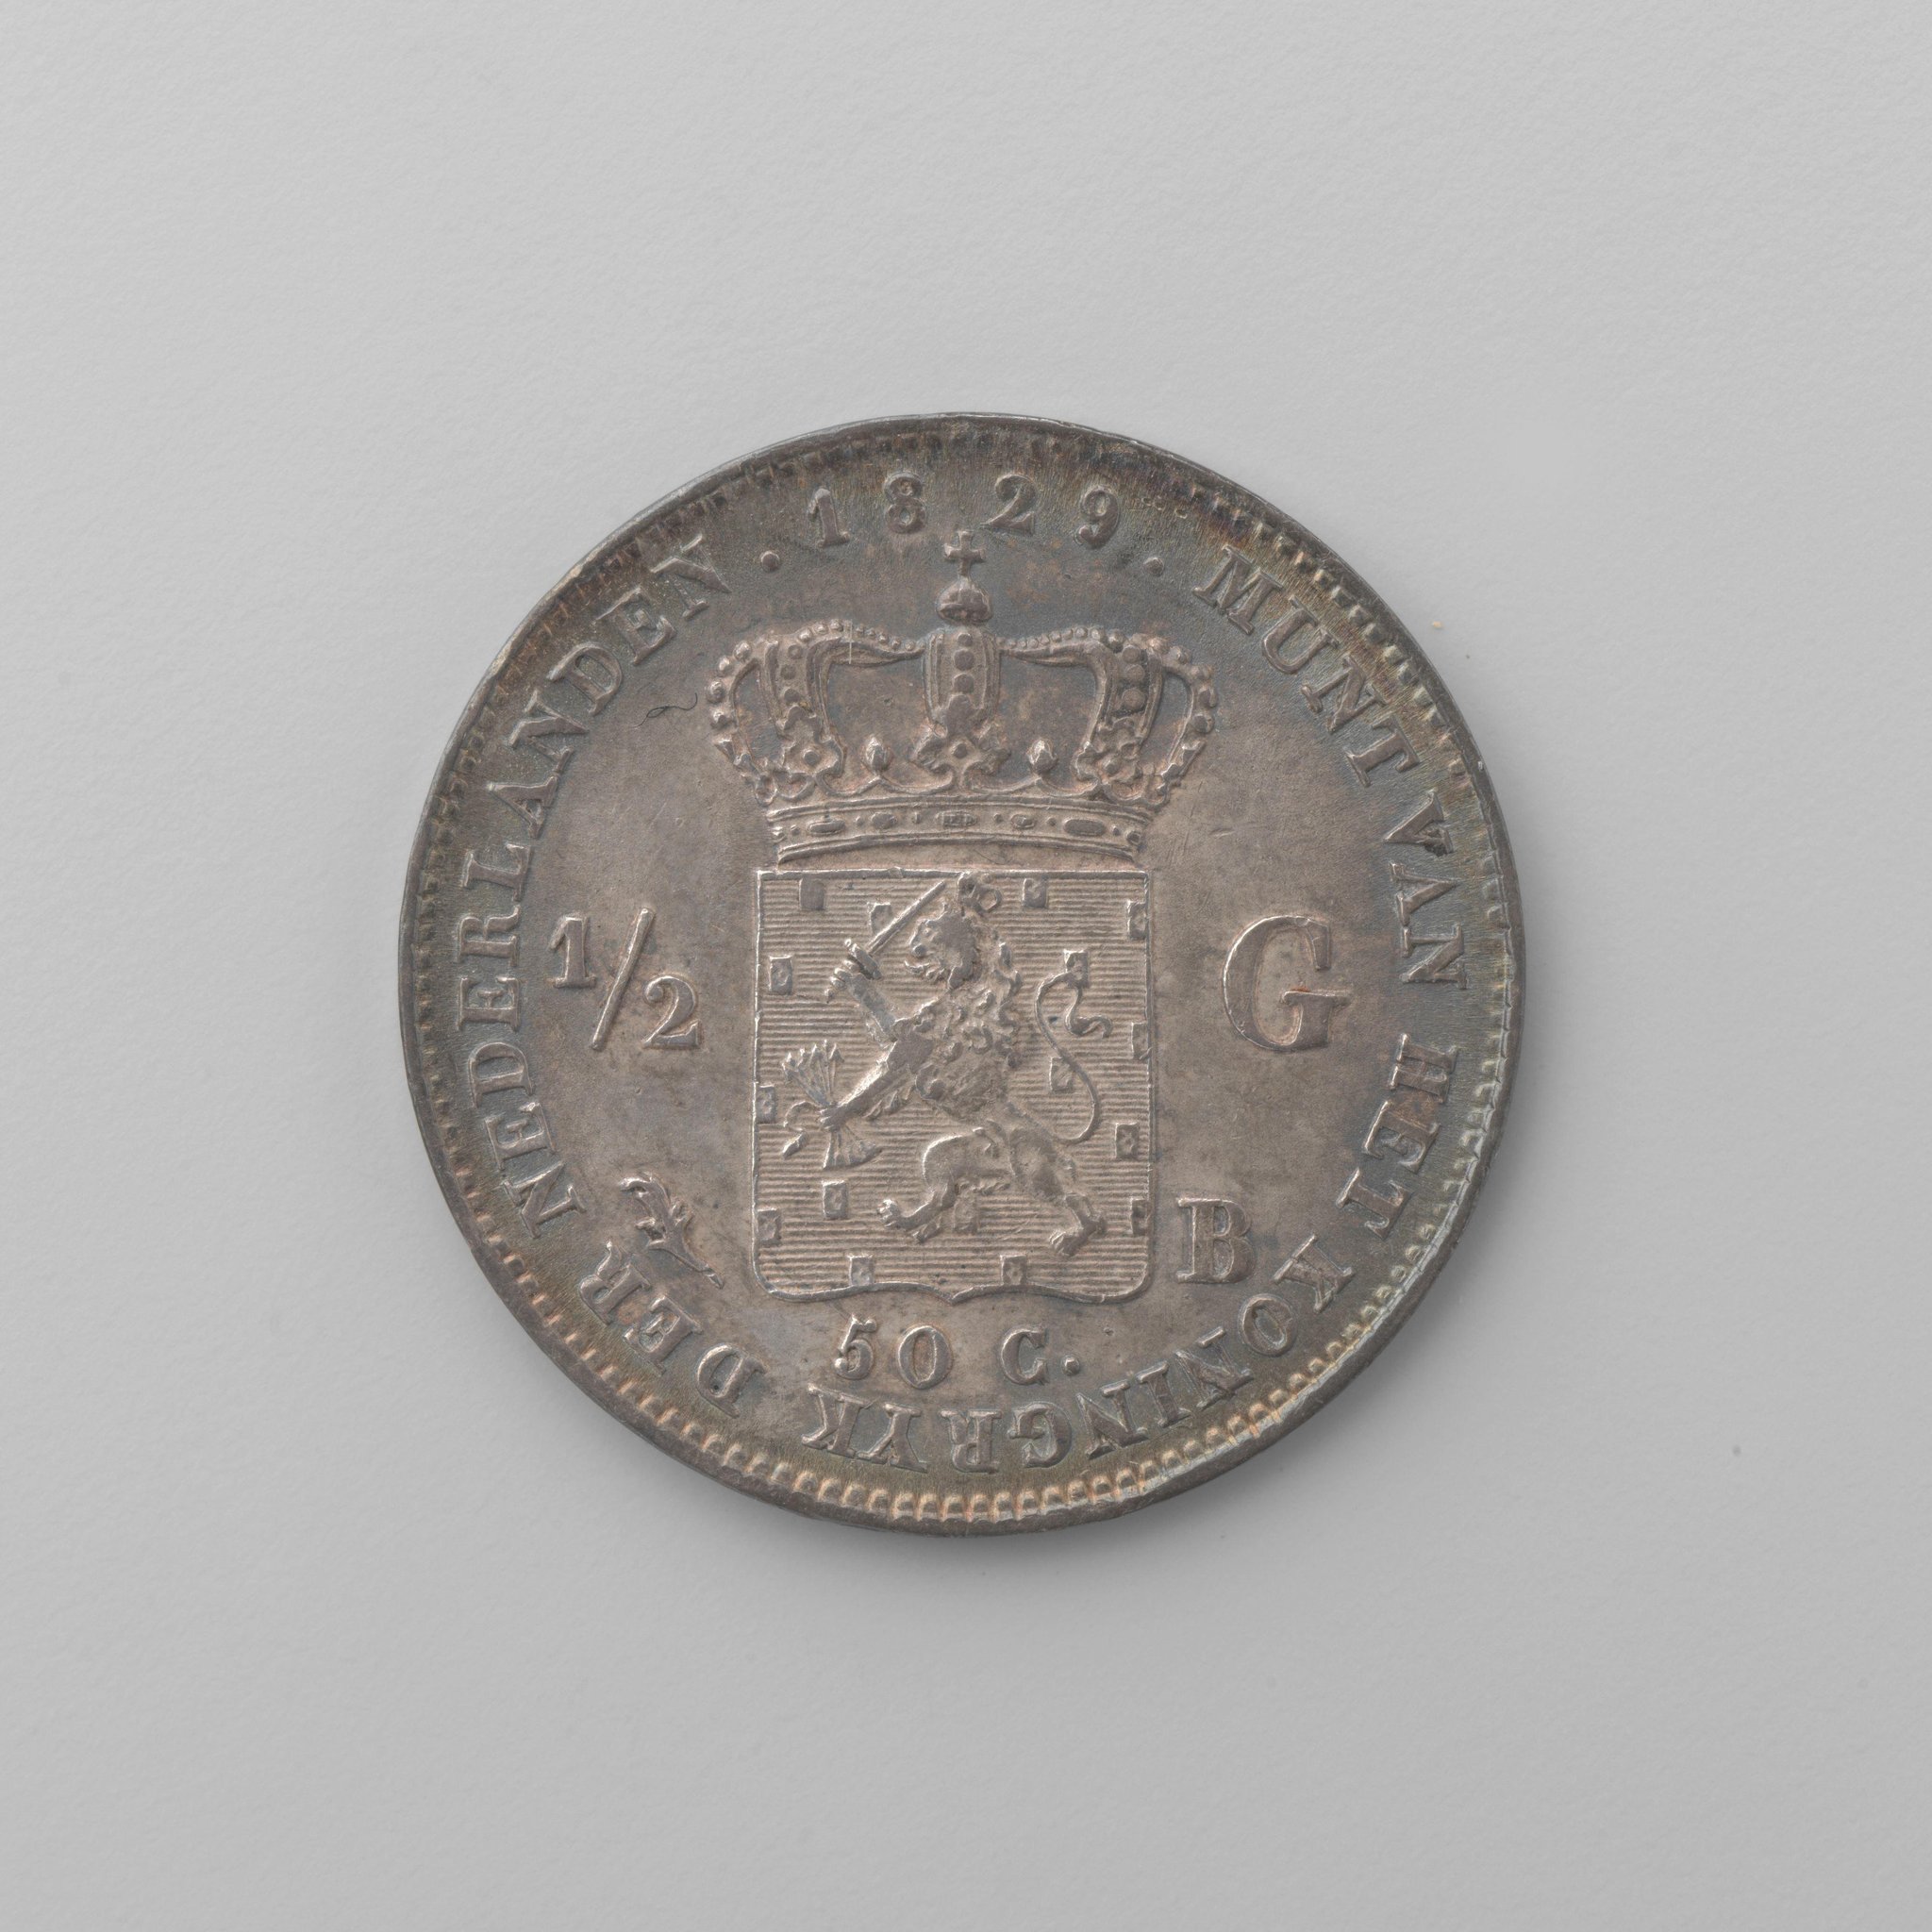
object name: coin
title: Nederland, ½ gulden,1829 B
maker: william i of the netherlands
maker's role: koning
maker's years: 1772-1843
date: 1829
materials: silver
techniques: striking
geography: brussels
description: Zilveren munt. Voorzijde: borstbeeld naar rechts. Keerzijde: tussen waarde-aanduiding ½ G gekroond rijkswapenschild. Jaartal boven kroon. Randschrift.